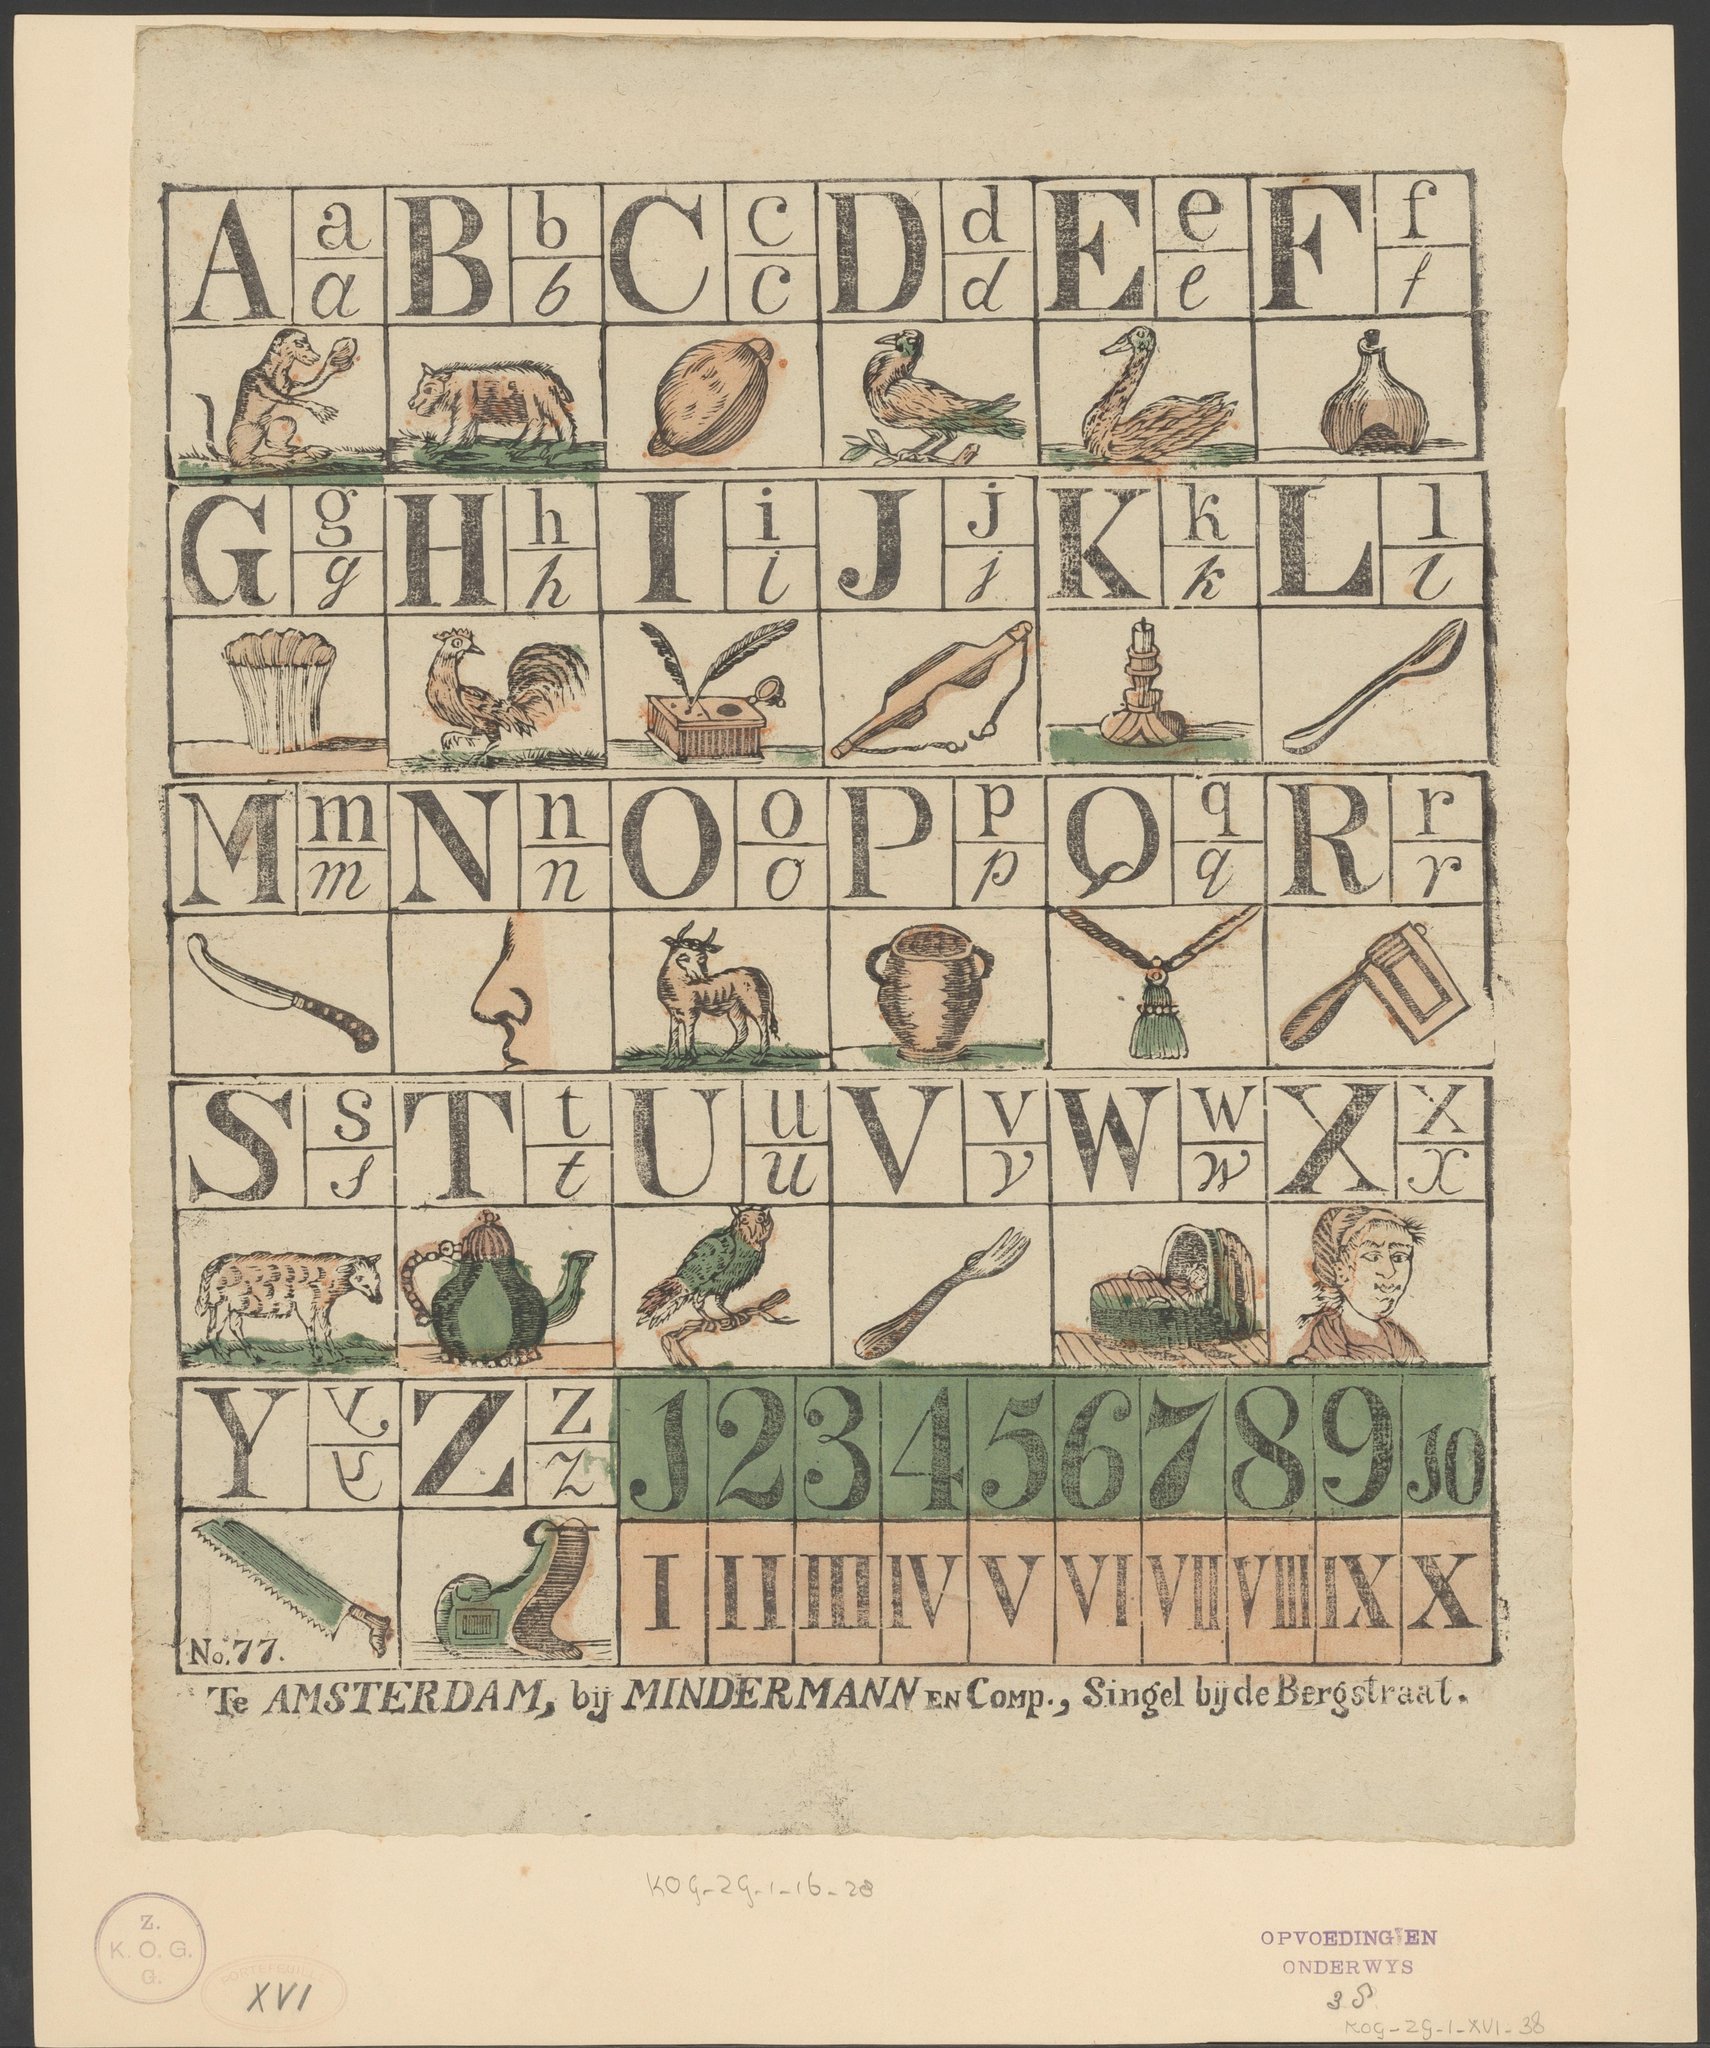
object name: popular print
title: Alfabet en cijfers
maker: Anonymous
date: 1814-1848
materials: paper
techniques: hand coloring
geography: amsterdam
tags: letters, alphabet, script, counting, calculating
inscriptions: stamp, collector's mark: Lugt 1641, stamp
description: Blad met vijfentwintig voorstellingen die elk zijn onderverdeeld in kleinere vakjes. In deze vakjes voorstellingen van cijfers en de letters van het alfabet geïllustreerd met voorwerpen, dieren en figuren waarvan de woorden met de betreffende letter beginnen. Genummerd linksonder: No. 77. Onderwerpsrubrieken binnen de Atlas Zeden en Gewoonten: Onderwijs en Wetenschappen, Opvoeding en Onderwijs, Haneboeken en schoolprenten.